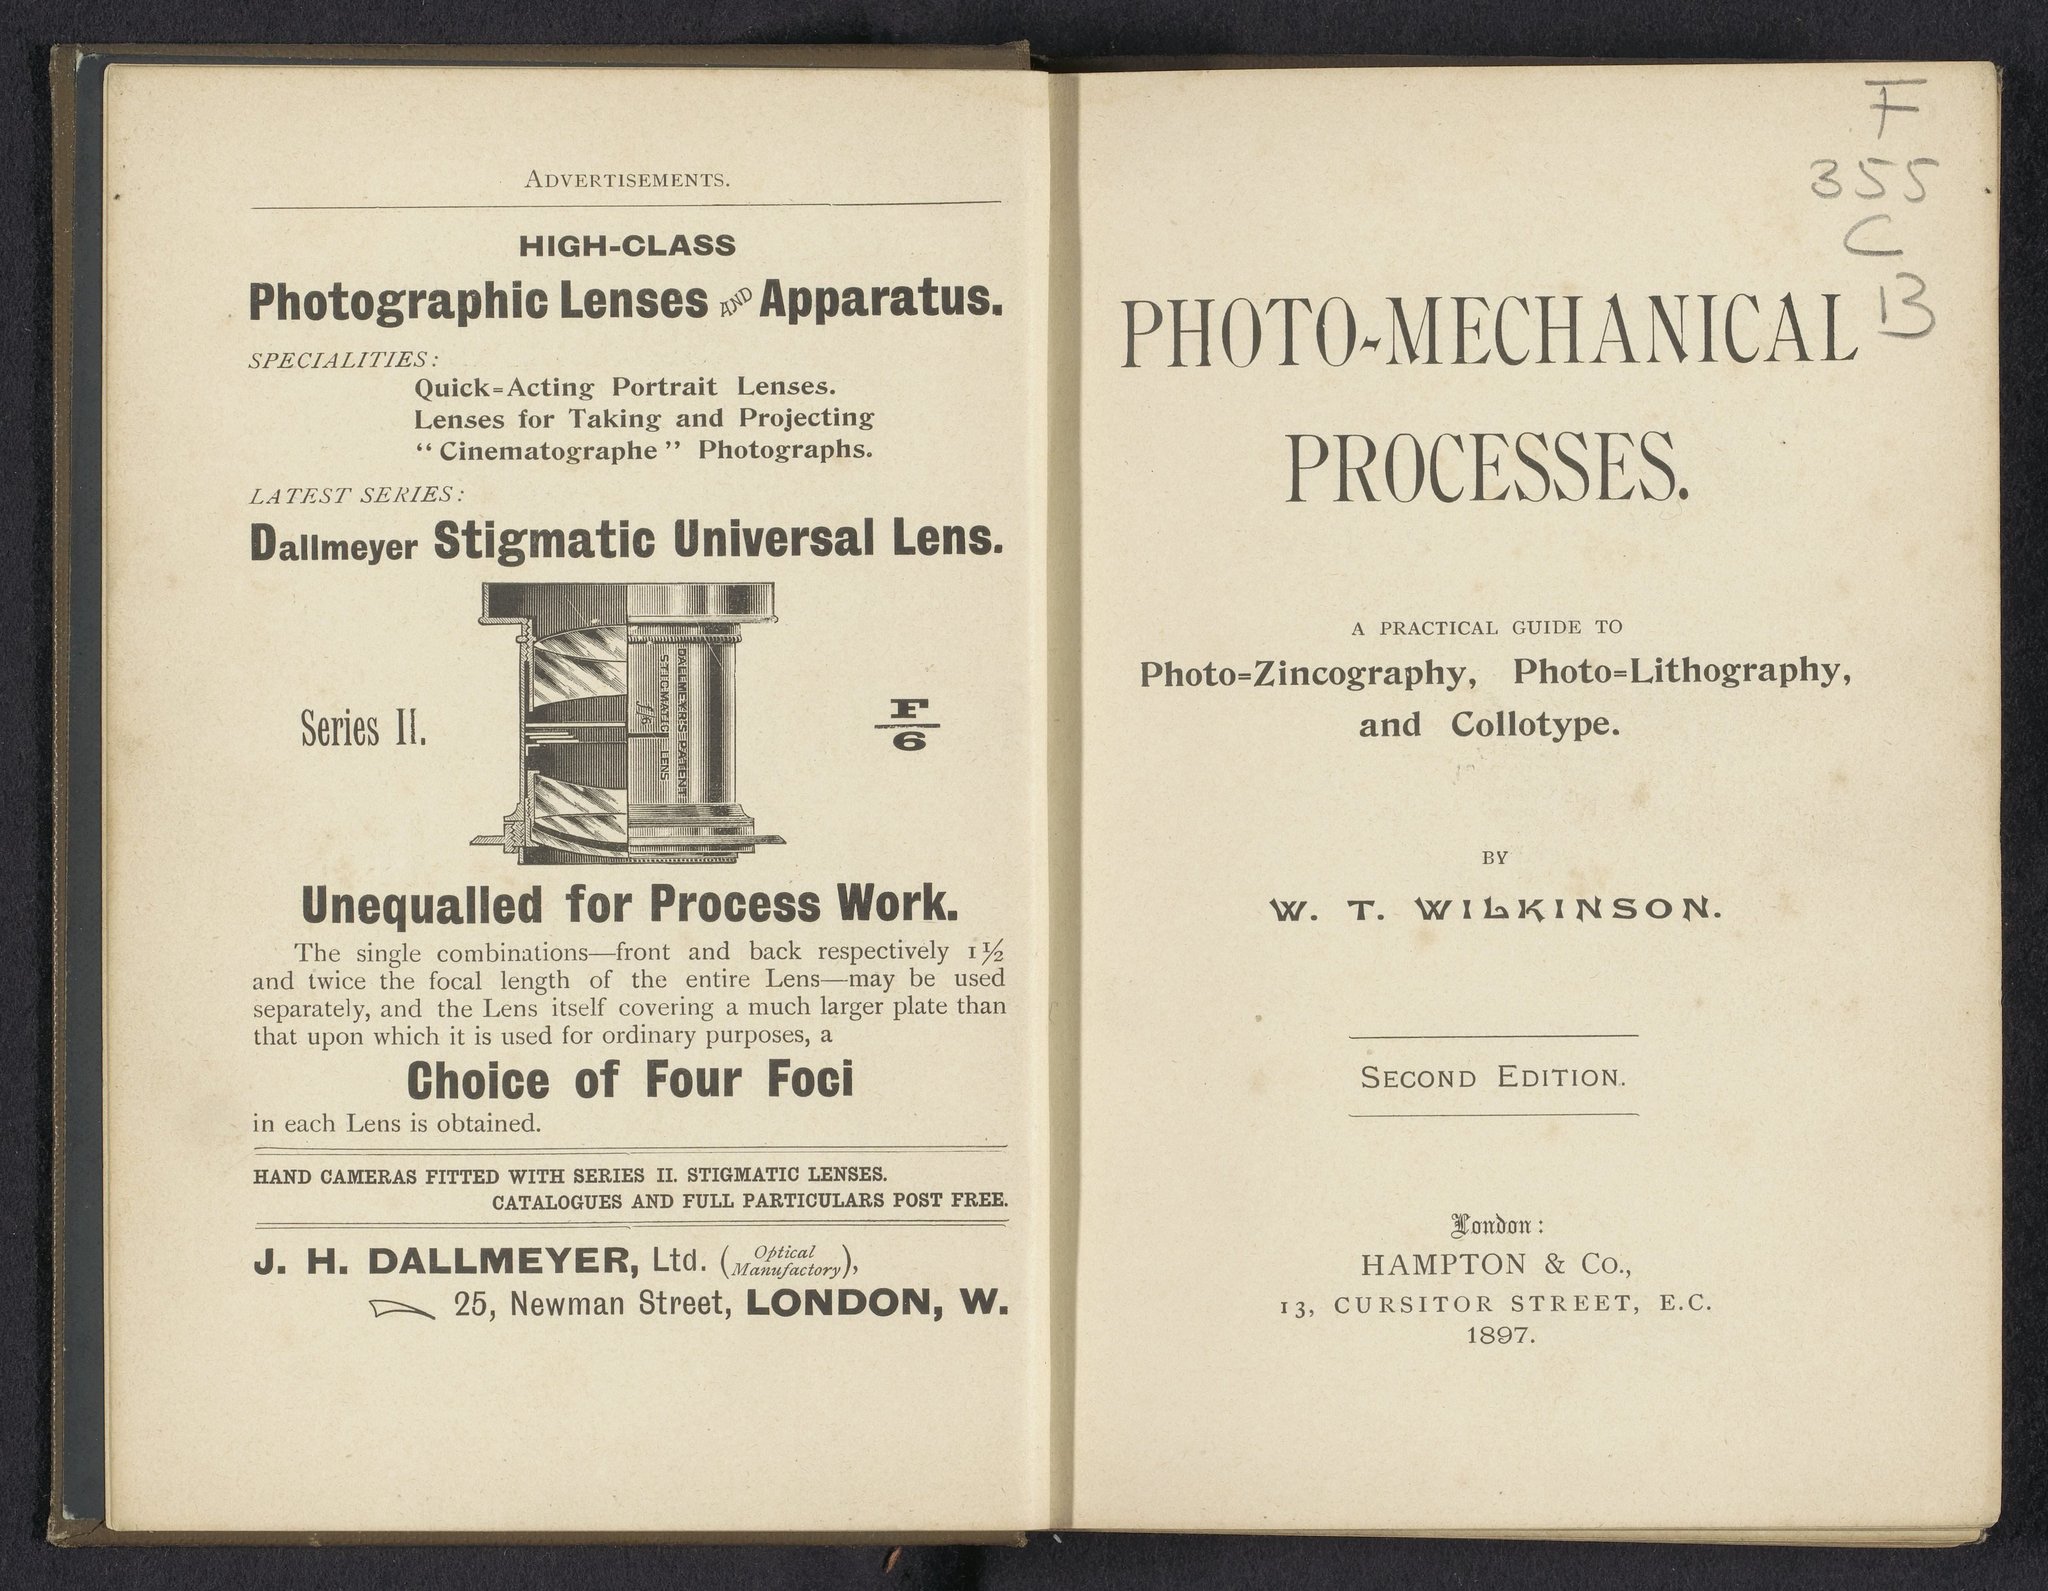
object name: book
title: Photo-mechanical processes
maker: w.t. wilkinson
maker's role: auteur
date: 1897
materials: cardboard, linen, paper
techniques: printing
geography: london